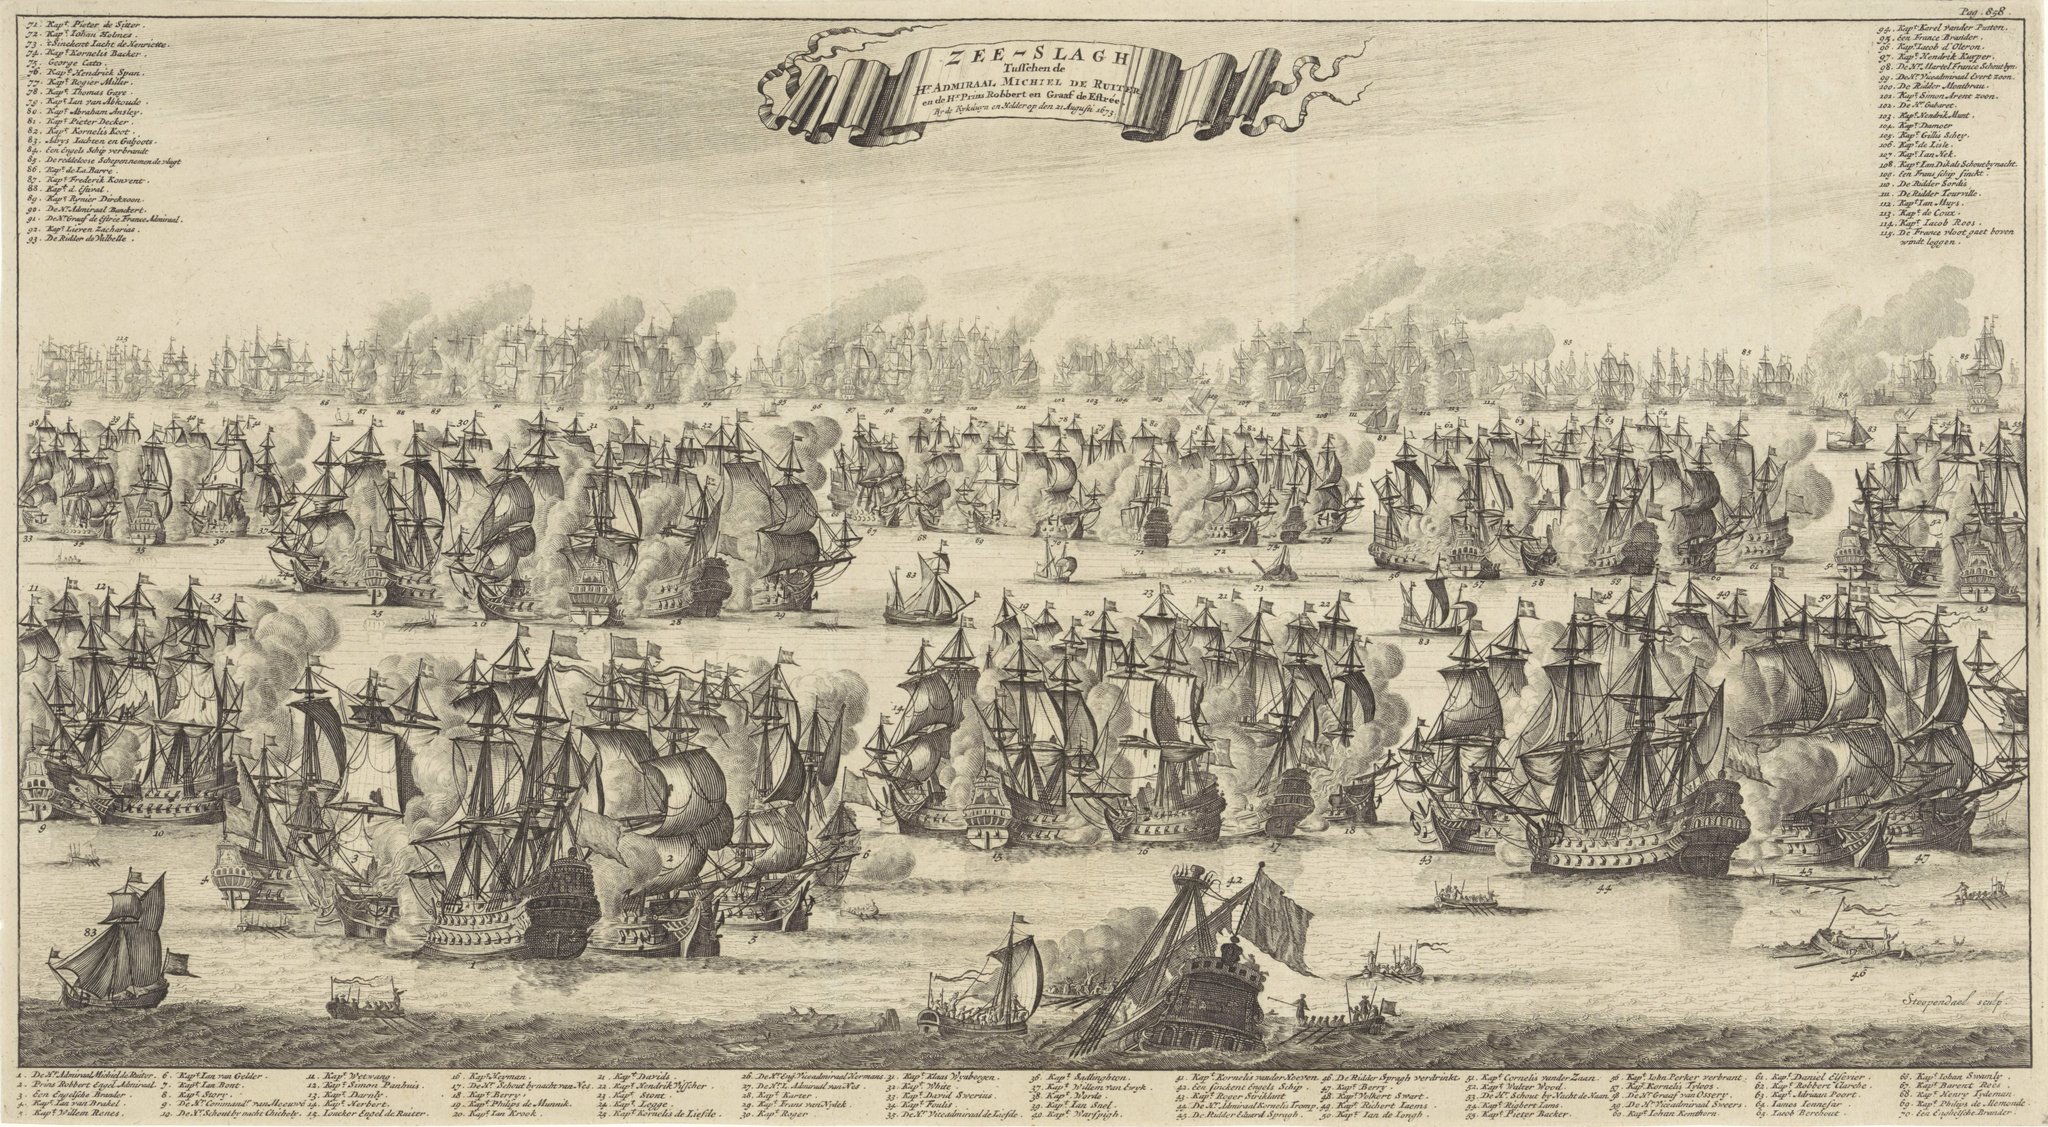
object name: history print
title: Zeeslag bij Kijkduin, 1673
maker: bastiaen stopendael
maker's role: print maker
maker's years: 1636-1693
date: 1687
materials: paper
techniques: engraving, etching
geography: amsterdam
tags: prague, london, painter, print maker, draughtsman, prinz ruprecht, flushing, michiel adriaenszoon de ruyter, rotterdam, amsterdam, cornelis tromp, battle (+ naval force), battle of the texel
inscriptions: collector's mark: Lugt 2228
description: Zeeslag bij Kijkduin, 21 augustus 1673. Zeeslag voor Kijkduin bij Den Helder en Texel tussen de Staatse vloot onder Michiel Adriaenszoon de Ruyter en Cornelis Tromp en de gecombineerde Engels-Franse vloot onder prins Rupert en de graaf Jean d'Estrées (II). Onderaan en bovenaan de legenda 1-115 in 3 delen.